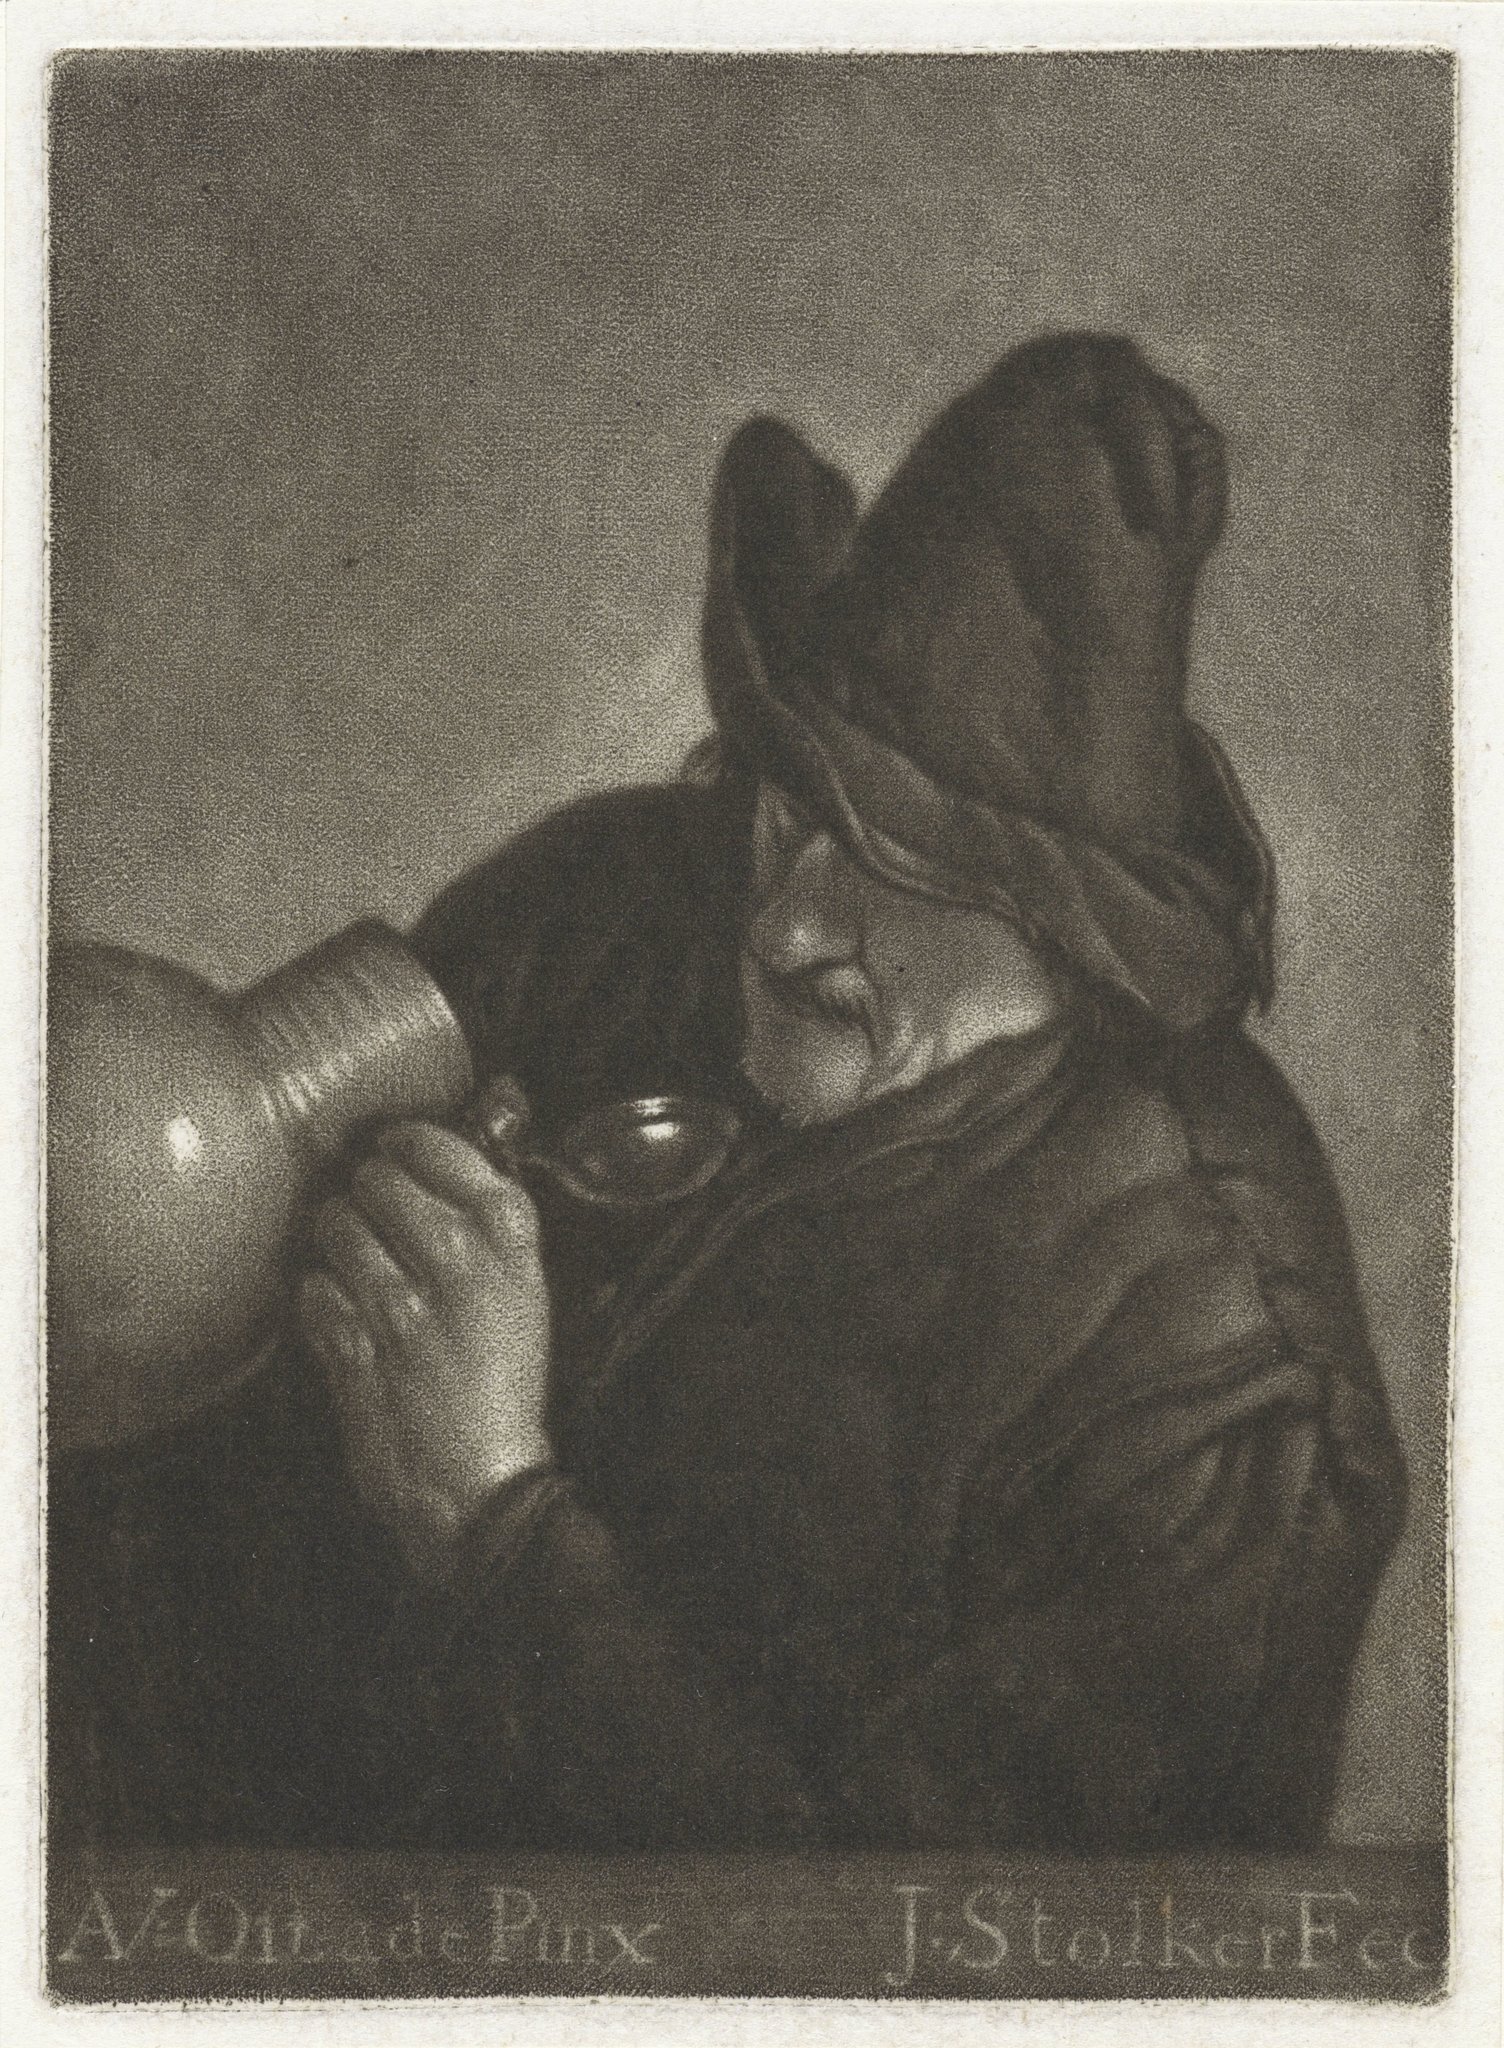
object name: print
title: Man kijkt in een lege kruik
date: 1734-1785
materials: paper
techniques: mezzotint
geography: northern netherlands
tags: jar, jug (used as drinking-vessel), head-gear: hat (+ men's clothes)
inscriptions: collector's mark: Lugt 240